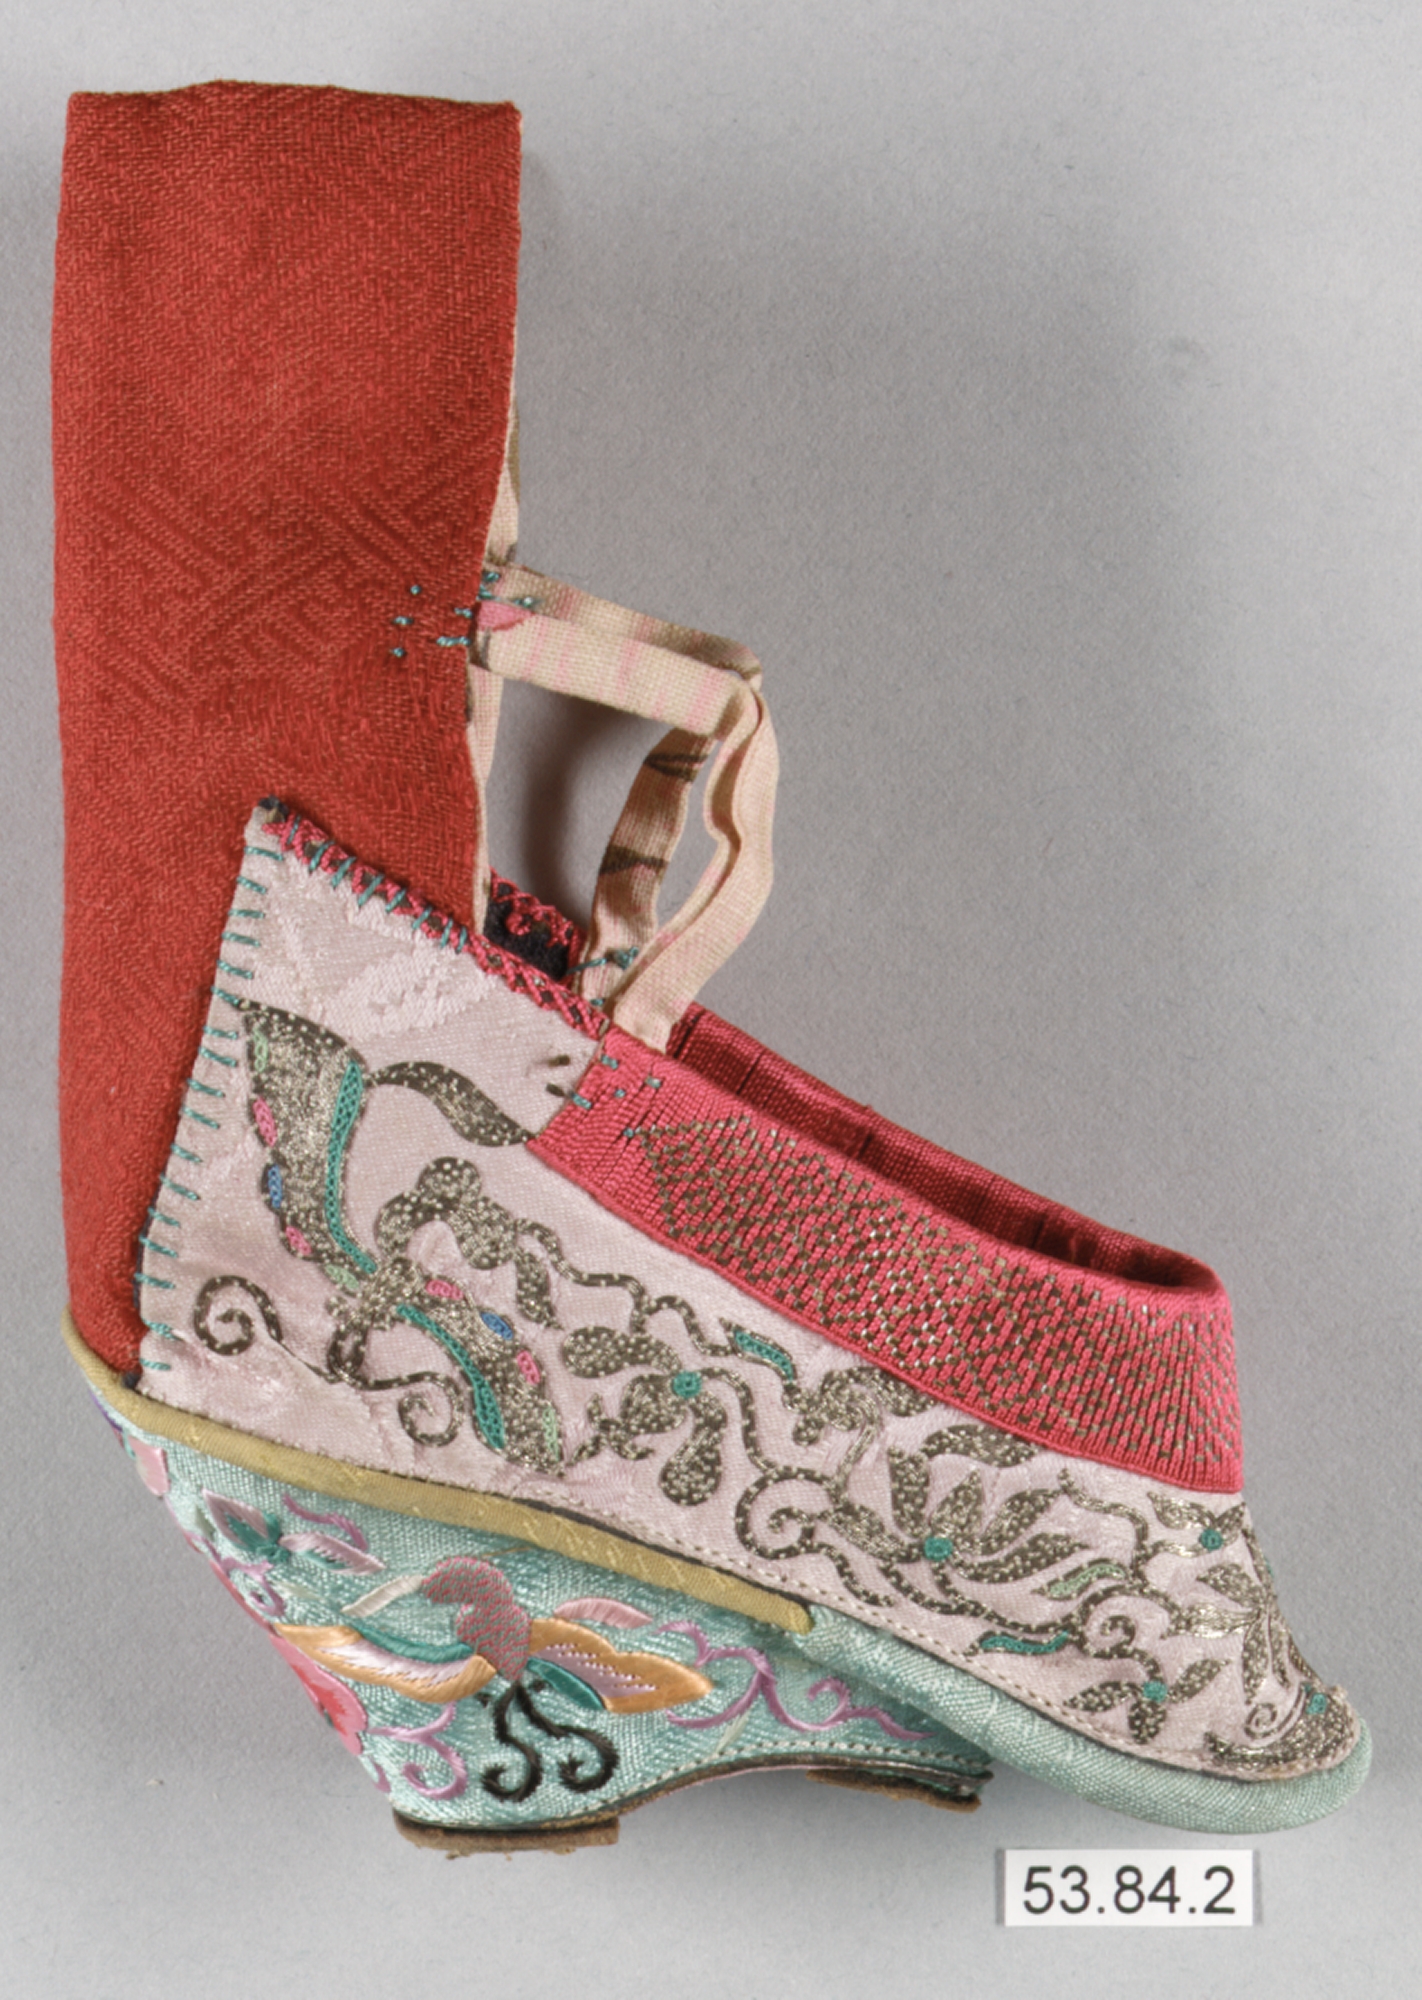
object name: woman's shoe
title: Woman's Shoe for Bound Feet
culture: chinese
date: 1801-2000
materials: leather, linen, metal thread, silk